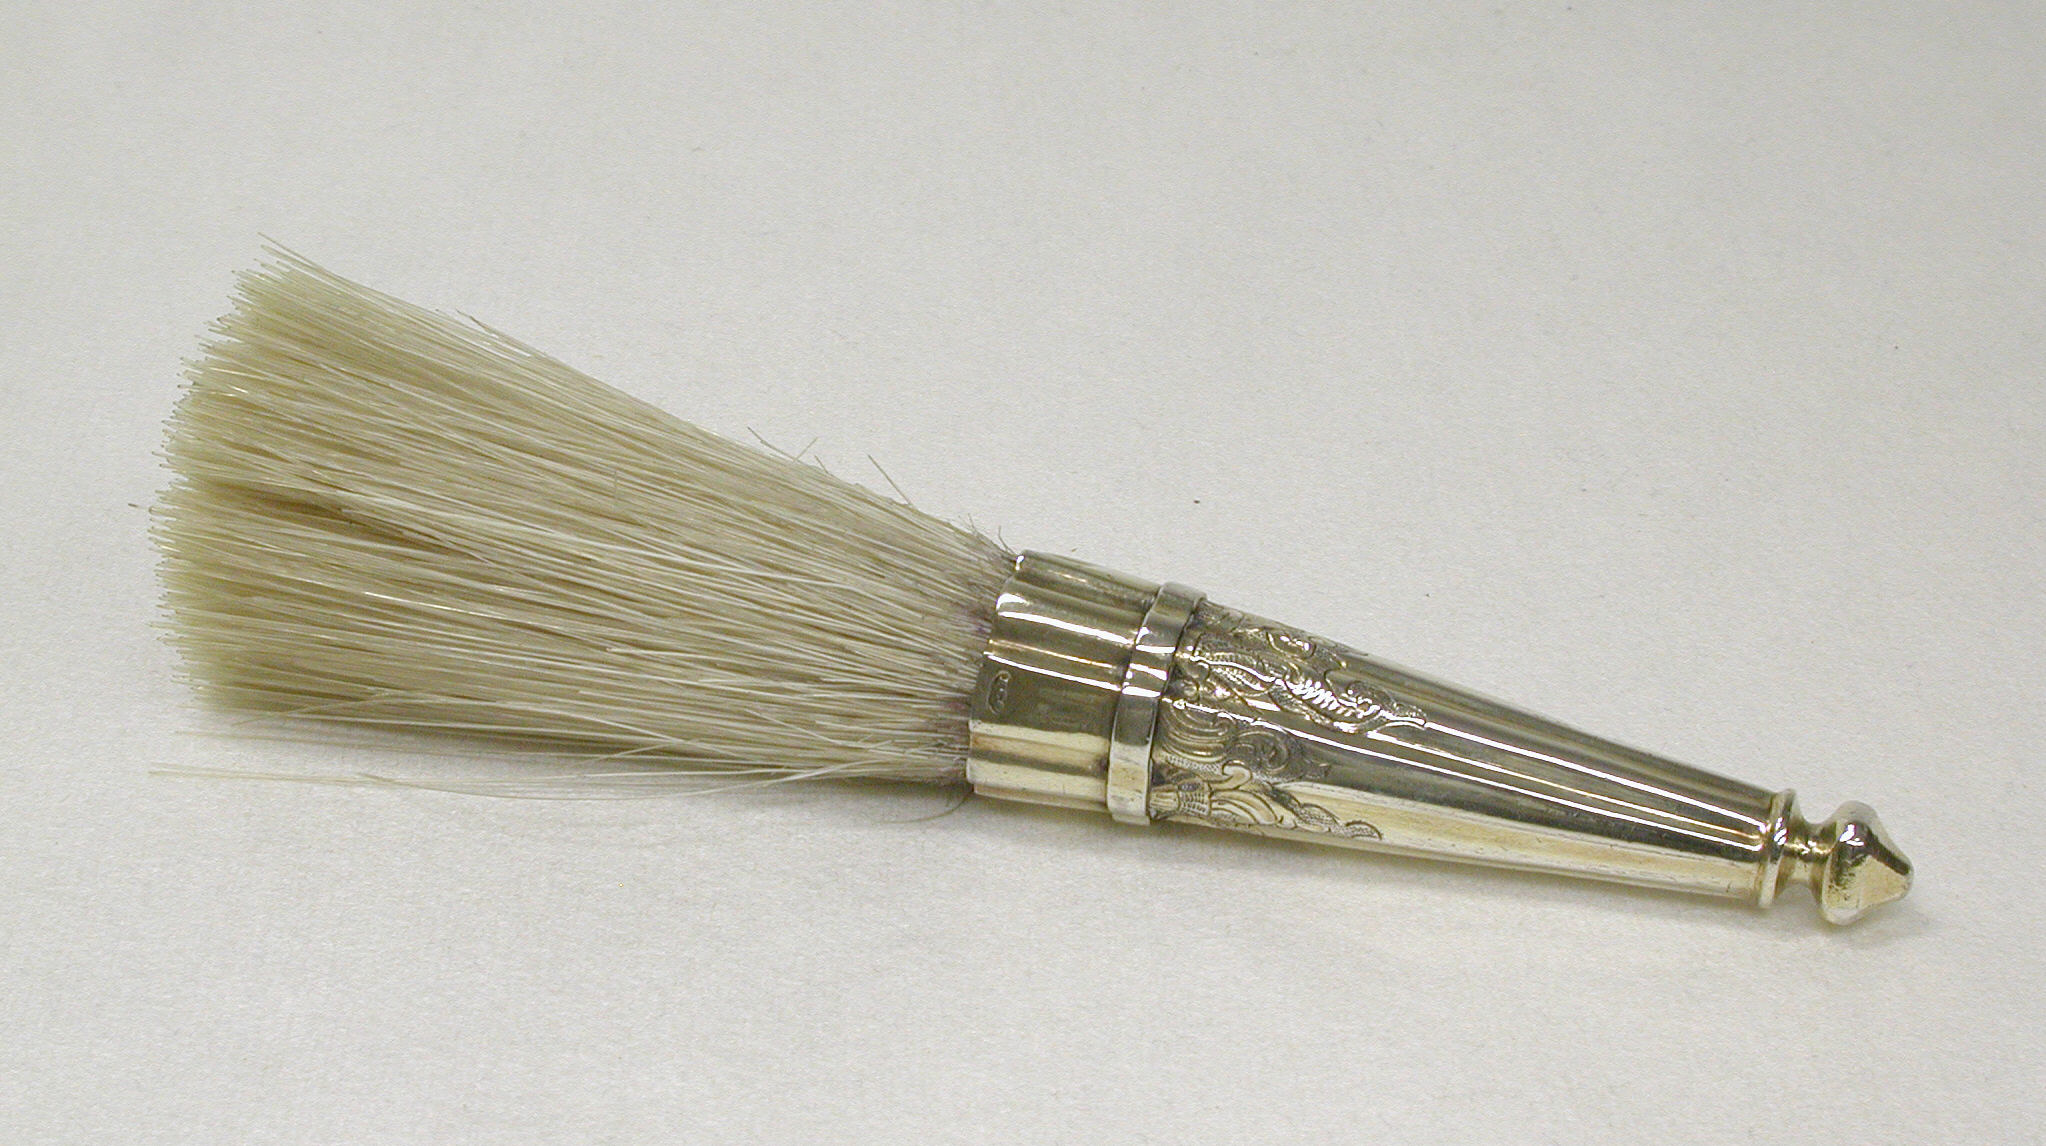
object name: clothes brush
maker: johann christoph stenglin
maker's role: maker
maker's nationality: german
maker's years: 1737-1775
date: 1743-1745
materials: hair, silver gilt